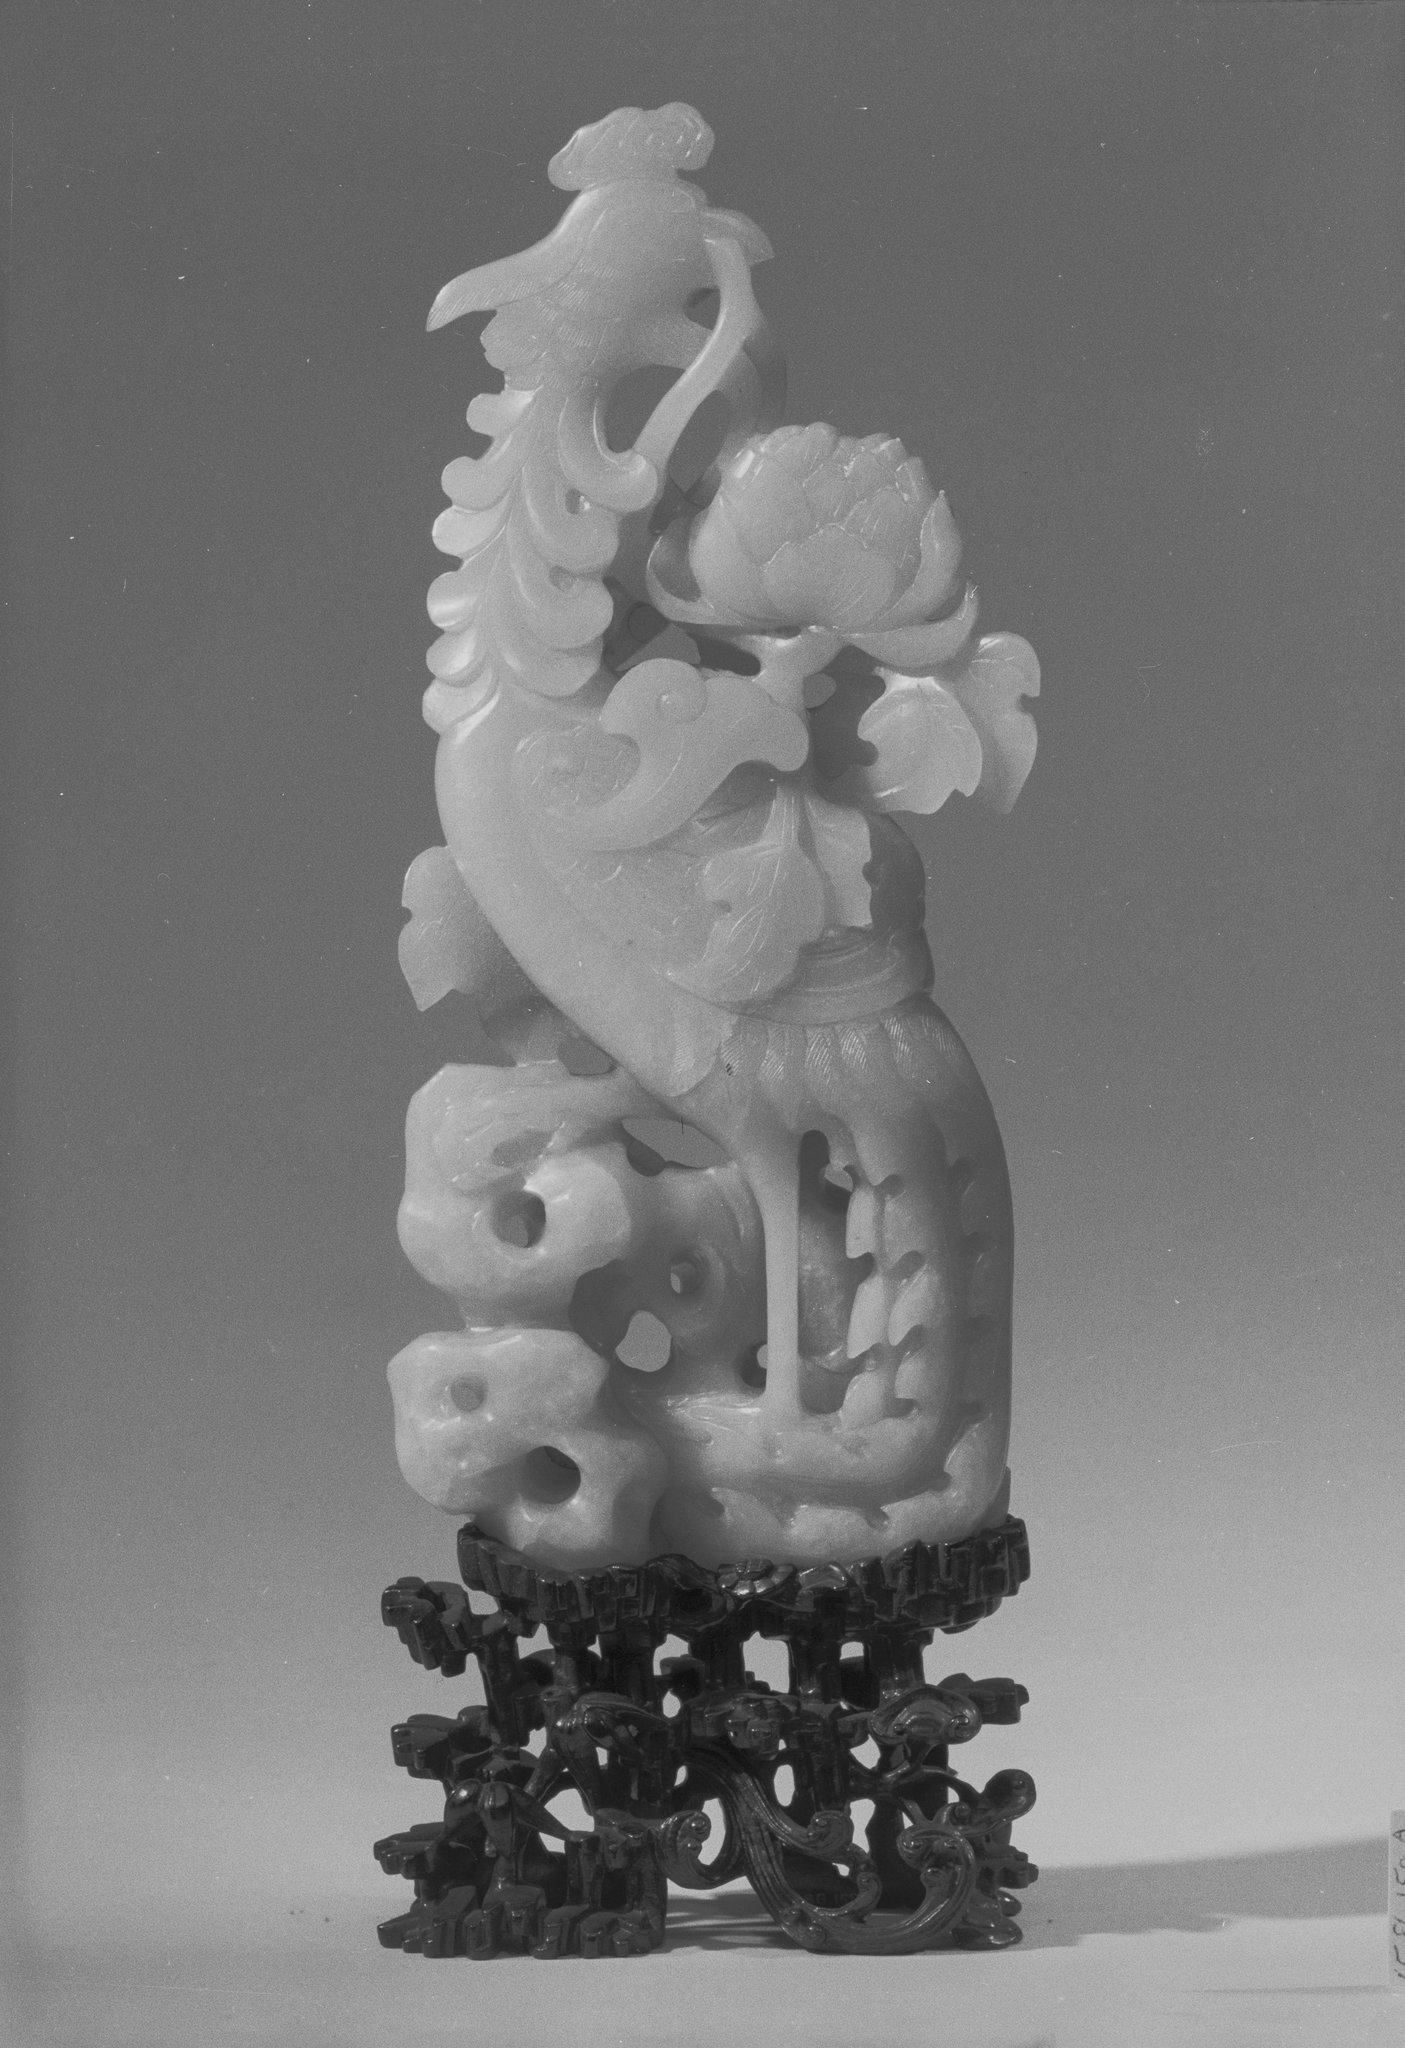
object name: figure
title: Figure of a Phoenix Standing amid Carved Foliage with Peony Motifs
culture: chinese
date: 1801-1900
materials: jade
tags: peonies